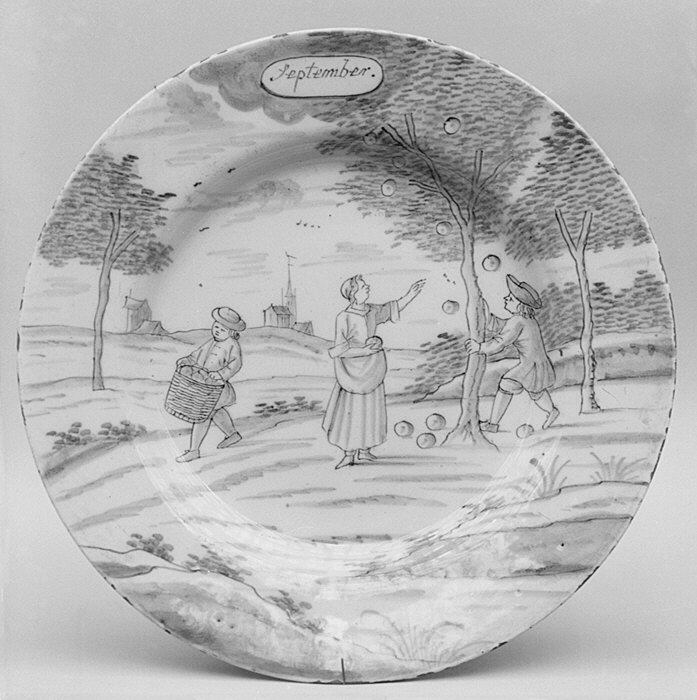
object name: plate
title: Plate (part of a set)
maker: de porceleyne bijl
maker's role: maker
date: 1764-1788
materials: earthenware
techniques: glazing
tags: fruit,children,women,trees